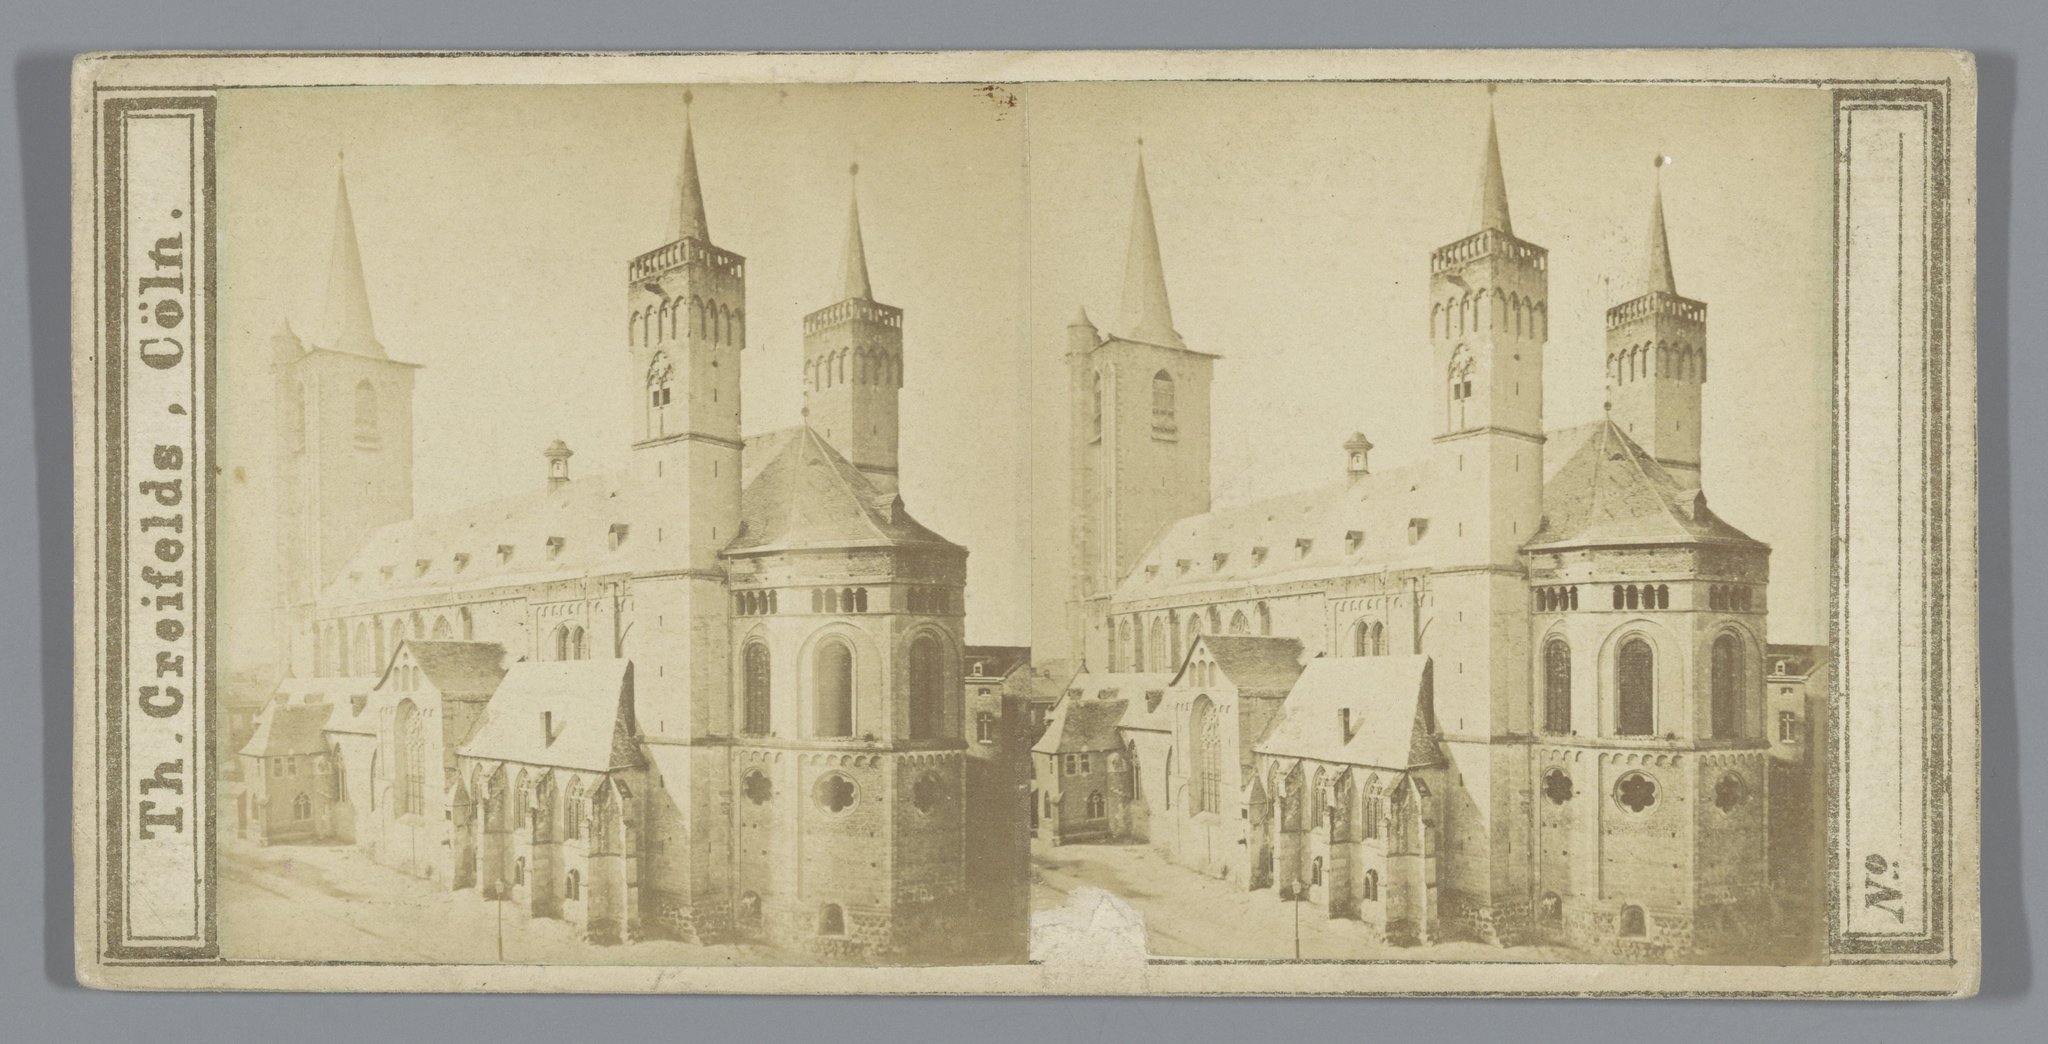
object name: stereograph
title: Exterieur van de Sint-Severinuskerk te Keulen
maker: theodor creifelds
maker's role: publisher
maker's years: 1815-1875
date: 1860-1880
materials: cardboard, photographic support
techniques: albumen print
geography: cologne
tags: church (exterior), façade (of house or building)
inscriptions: number: ‘Nro. 34’